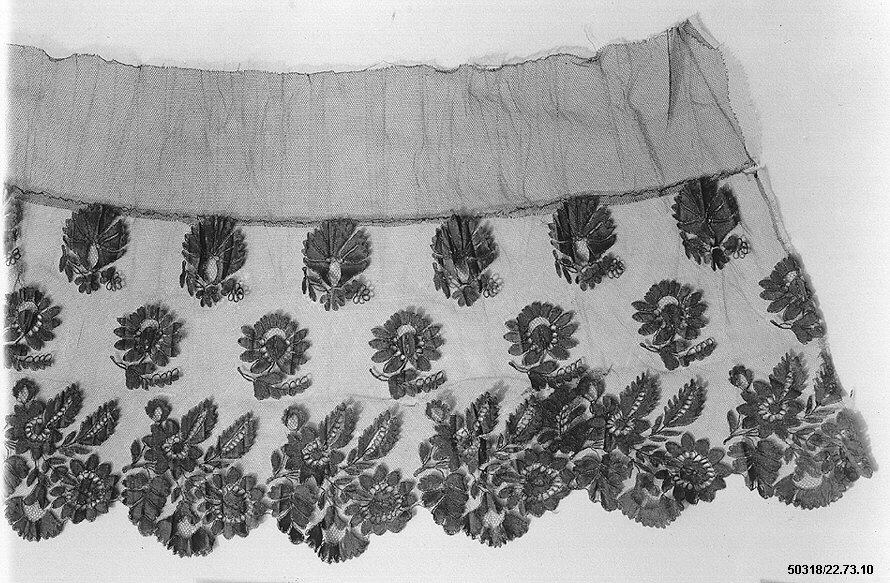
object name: strip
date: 1801-1900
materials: silk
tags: flowers